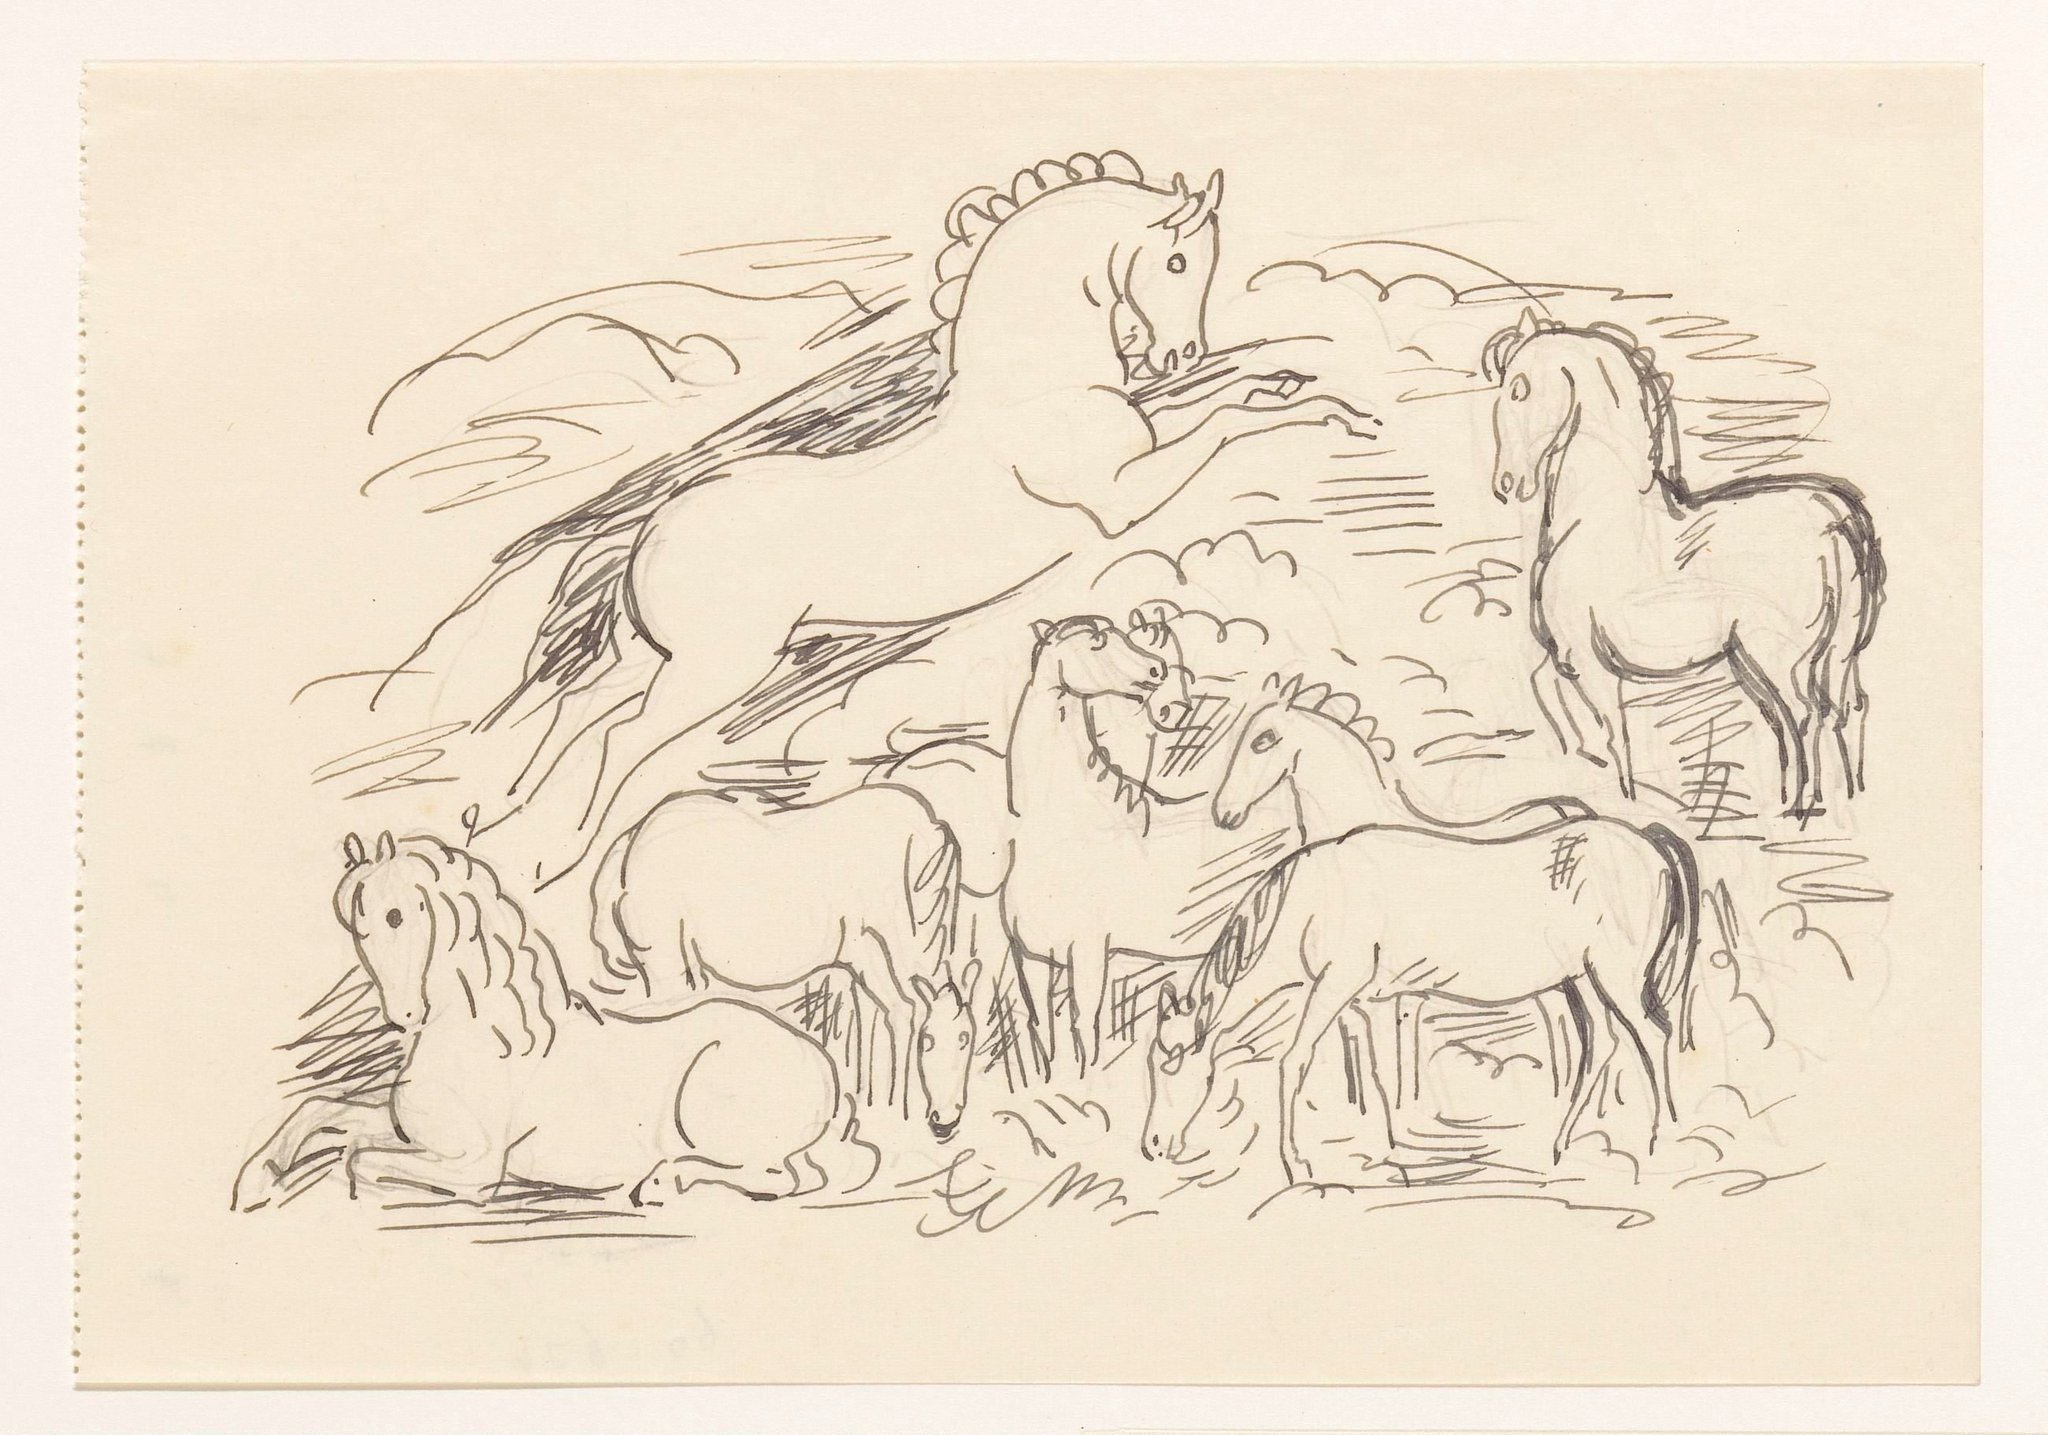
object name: drawing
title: Studieblad met acht paarden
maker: leo gestel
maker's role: draughtsman, print maker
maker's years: 1881-1941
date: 1891-1941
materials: ink, paper, pencil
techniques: pen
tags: horse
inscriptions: collector's mark: Lugt 2228